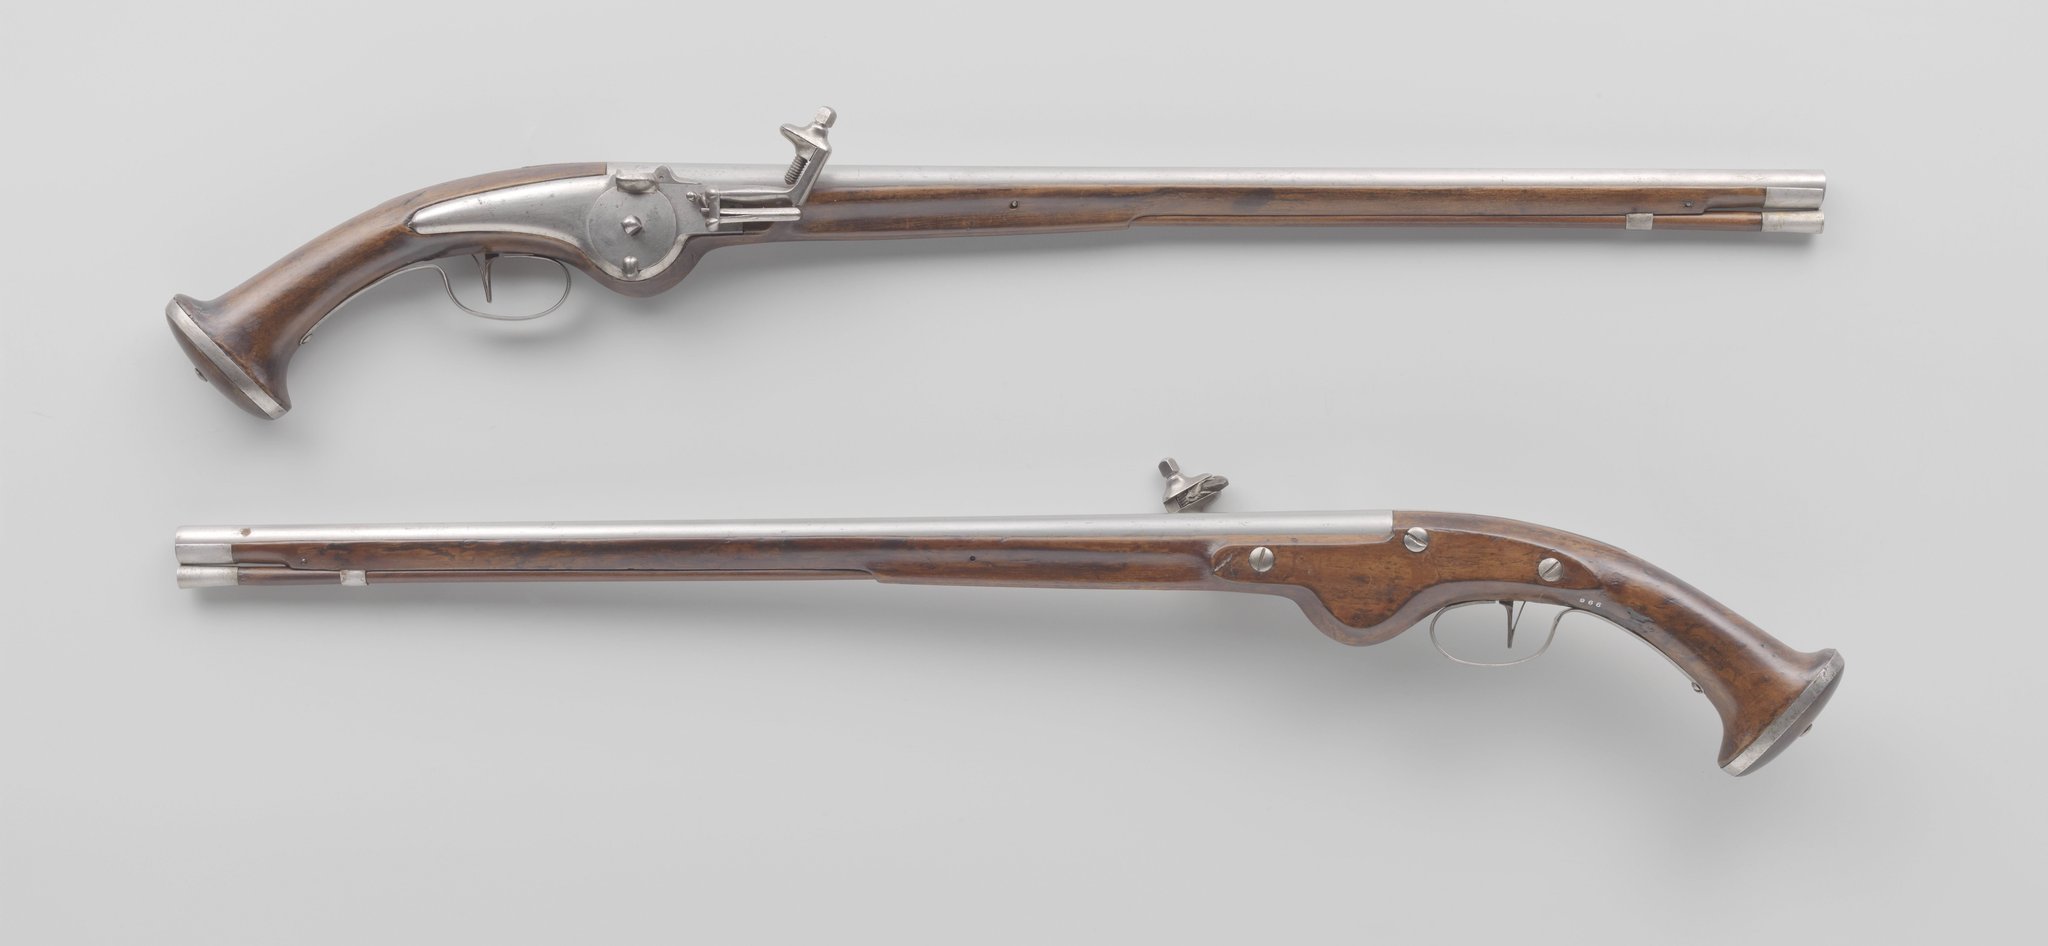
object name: radslotpistool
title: Wheellock pistol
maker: Anonymous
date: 1650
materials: brass, iron, wood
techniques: printing, cutting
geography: maastricht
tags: maastricht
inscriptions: mark: ‘3’, mark: ‘C.M.L. [...] (cf. St. 2262)’, : ‘o’, mark, number: ‘474’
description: These firearms are typically Dutch in that they are functional, slender and sober, yet elegant in design. The rounded lockplates are characteristic of Dutch wheellocks. This early manifestation of ‘Dutch design’ was valued far outside the Netherlands during the 17th century. These two wheellock pistols found their way to Germany, where they were owned by the Counts of Salm-Reifferscheidt- Dyck at Schloss Dyck in Westphalia.